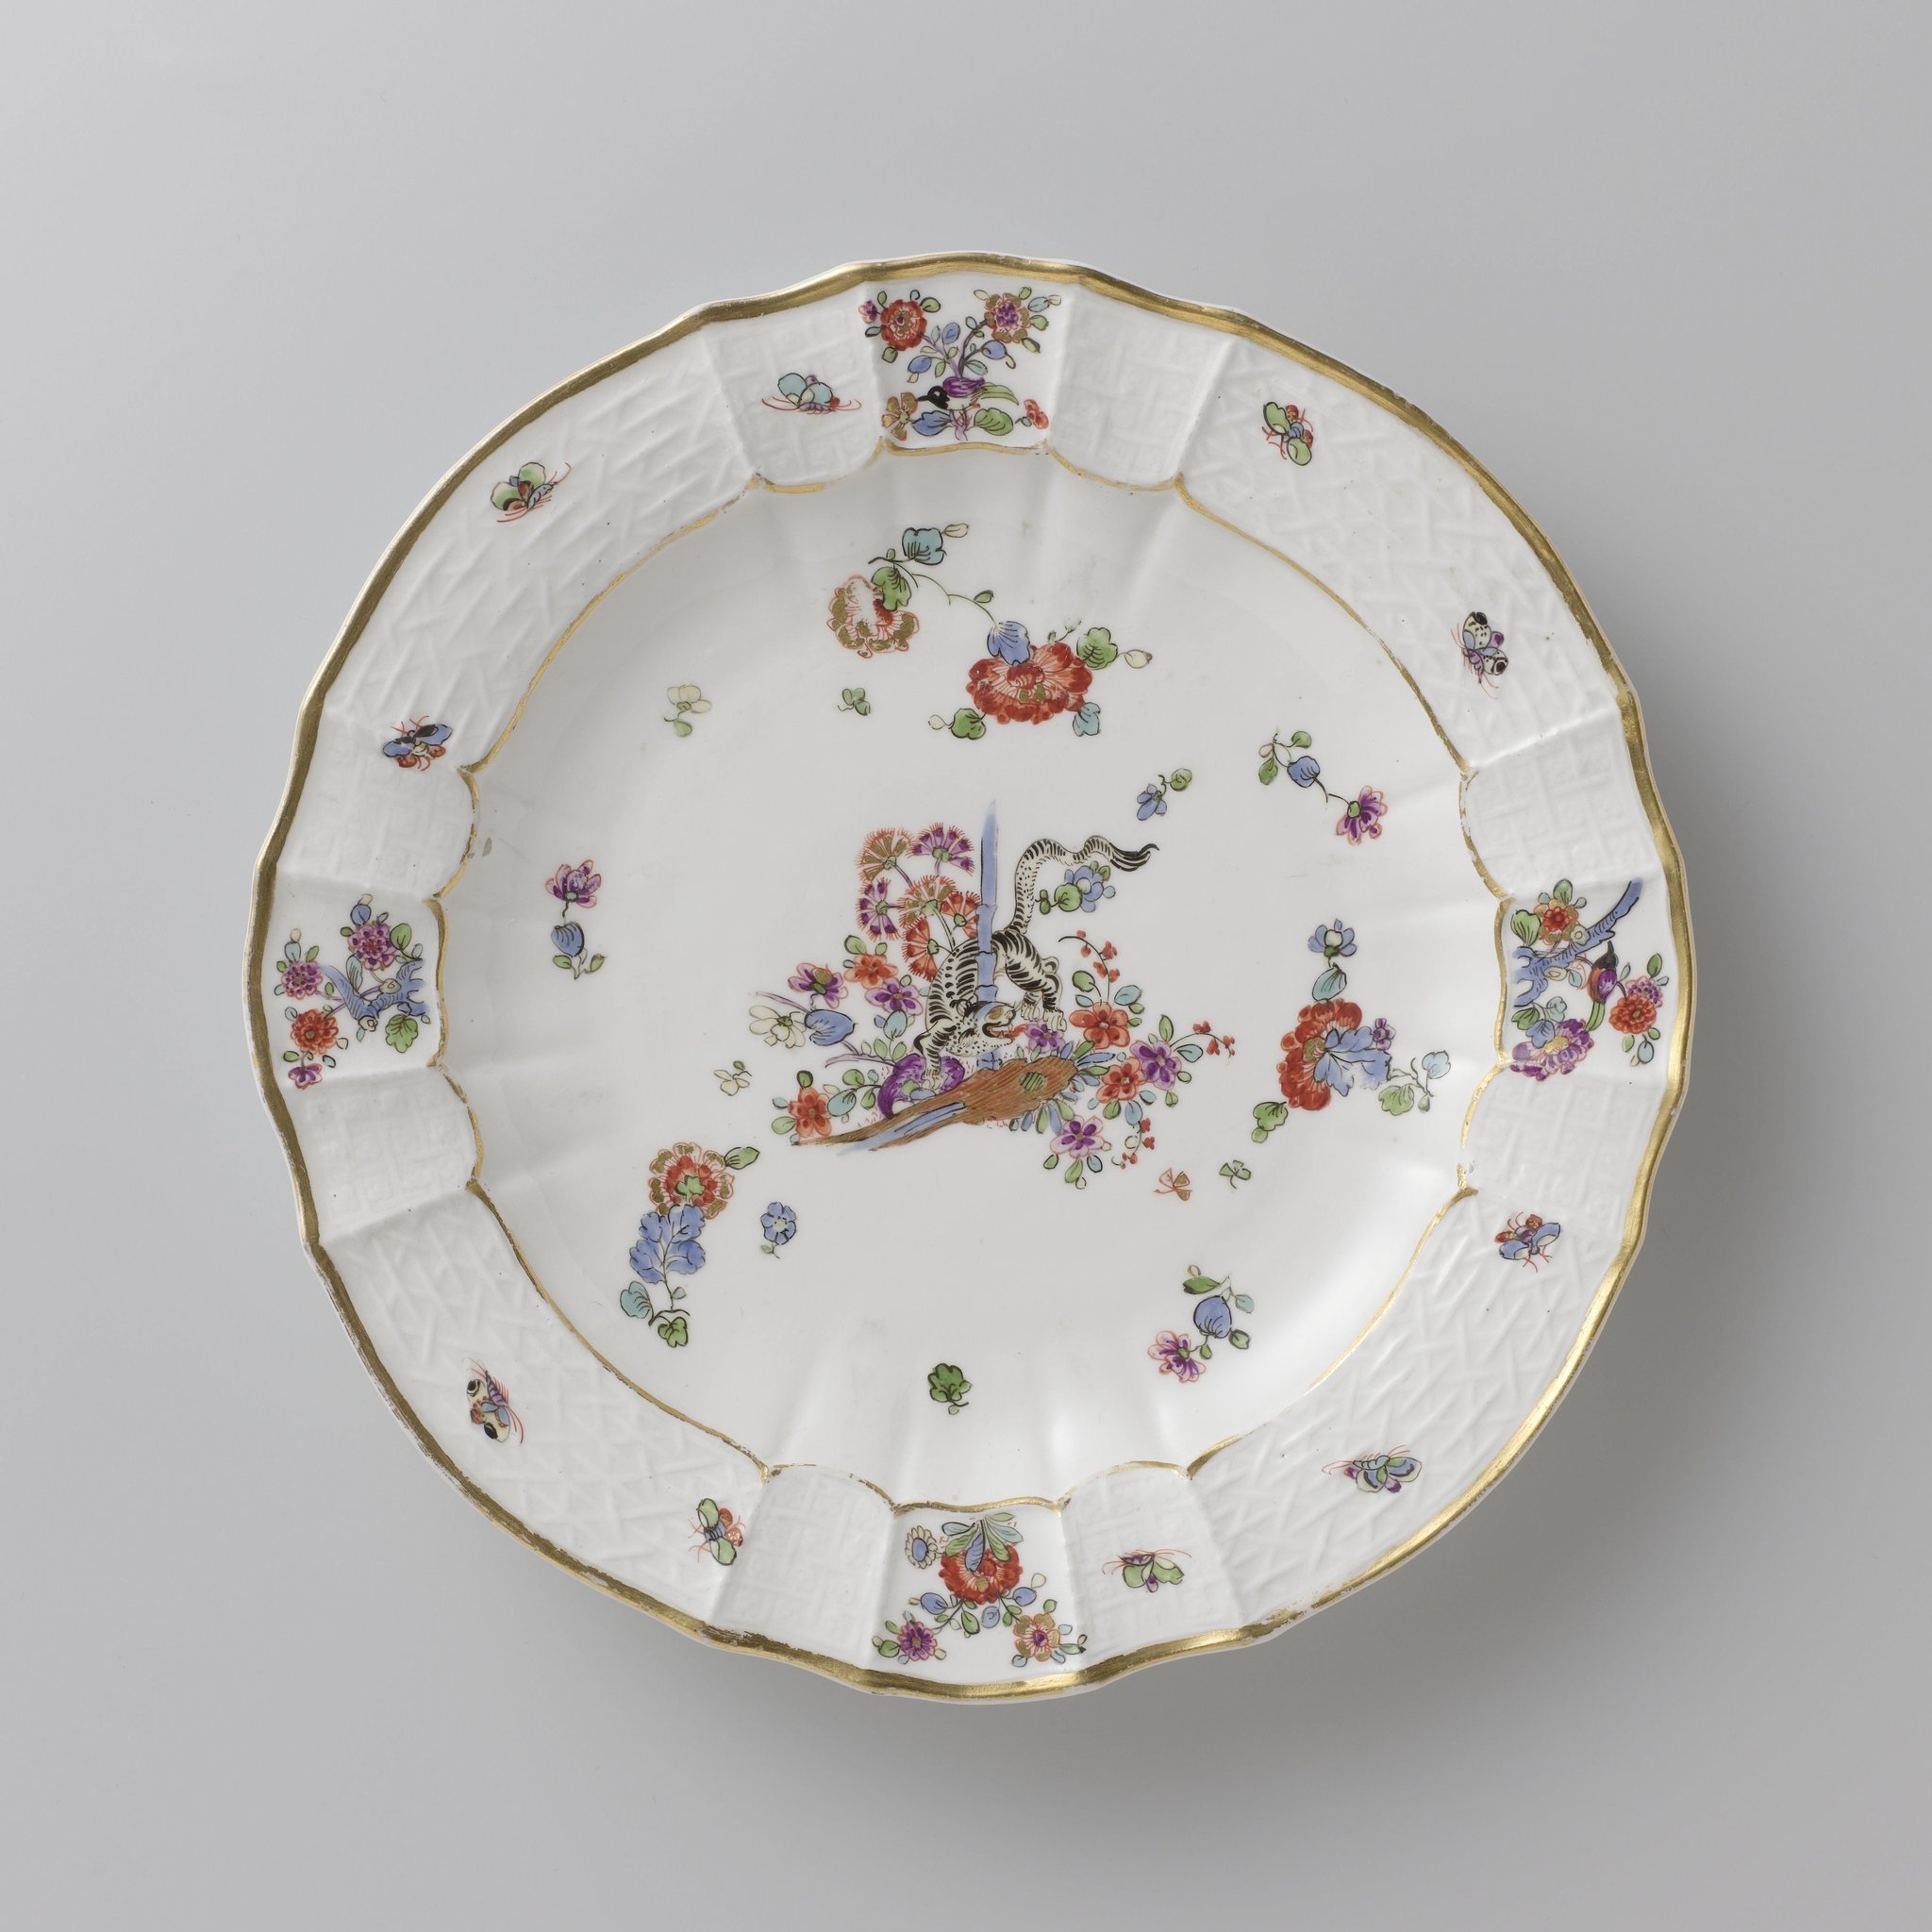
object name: eating drinking utensil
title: Rond bord, veelkleurig beschilderd met een Kakiemon-decor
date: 1740-1745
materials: porcelain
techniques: painted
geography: meissen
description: Rond bord van beschilderd porselein. Het bord is geribd en heeft een geschulpte rand. Het bord is beschilderd met een tijger die om een blauwe bamboestengel tussen bloemen is gedraaid, gestrooide Indianische Blumen, vlinders en takken waarop vogels. De rand is versierd met het 'Altbrandenstein'-patroon. Het bord is gemerkt.